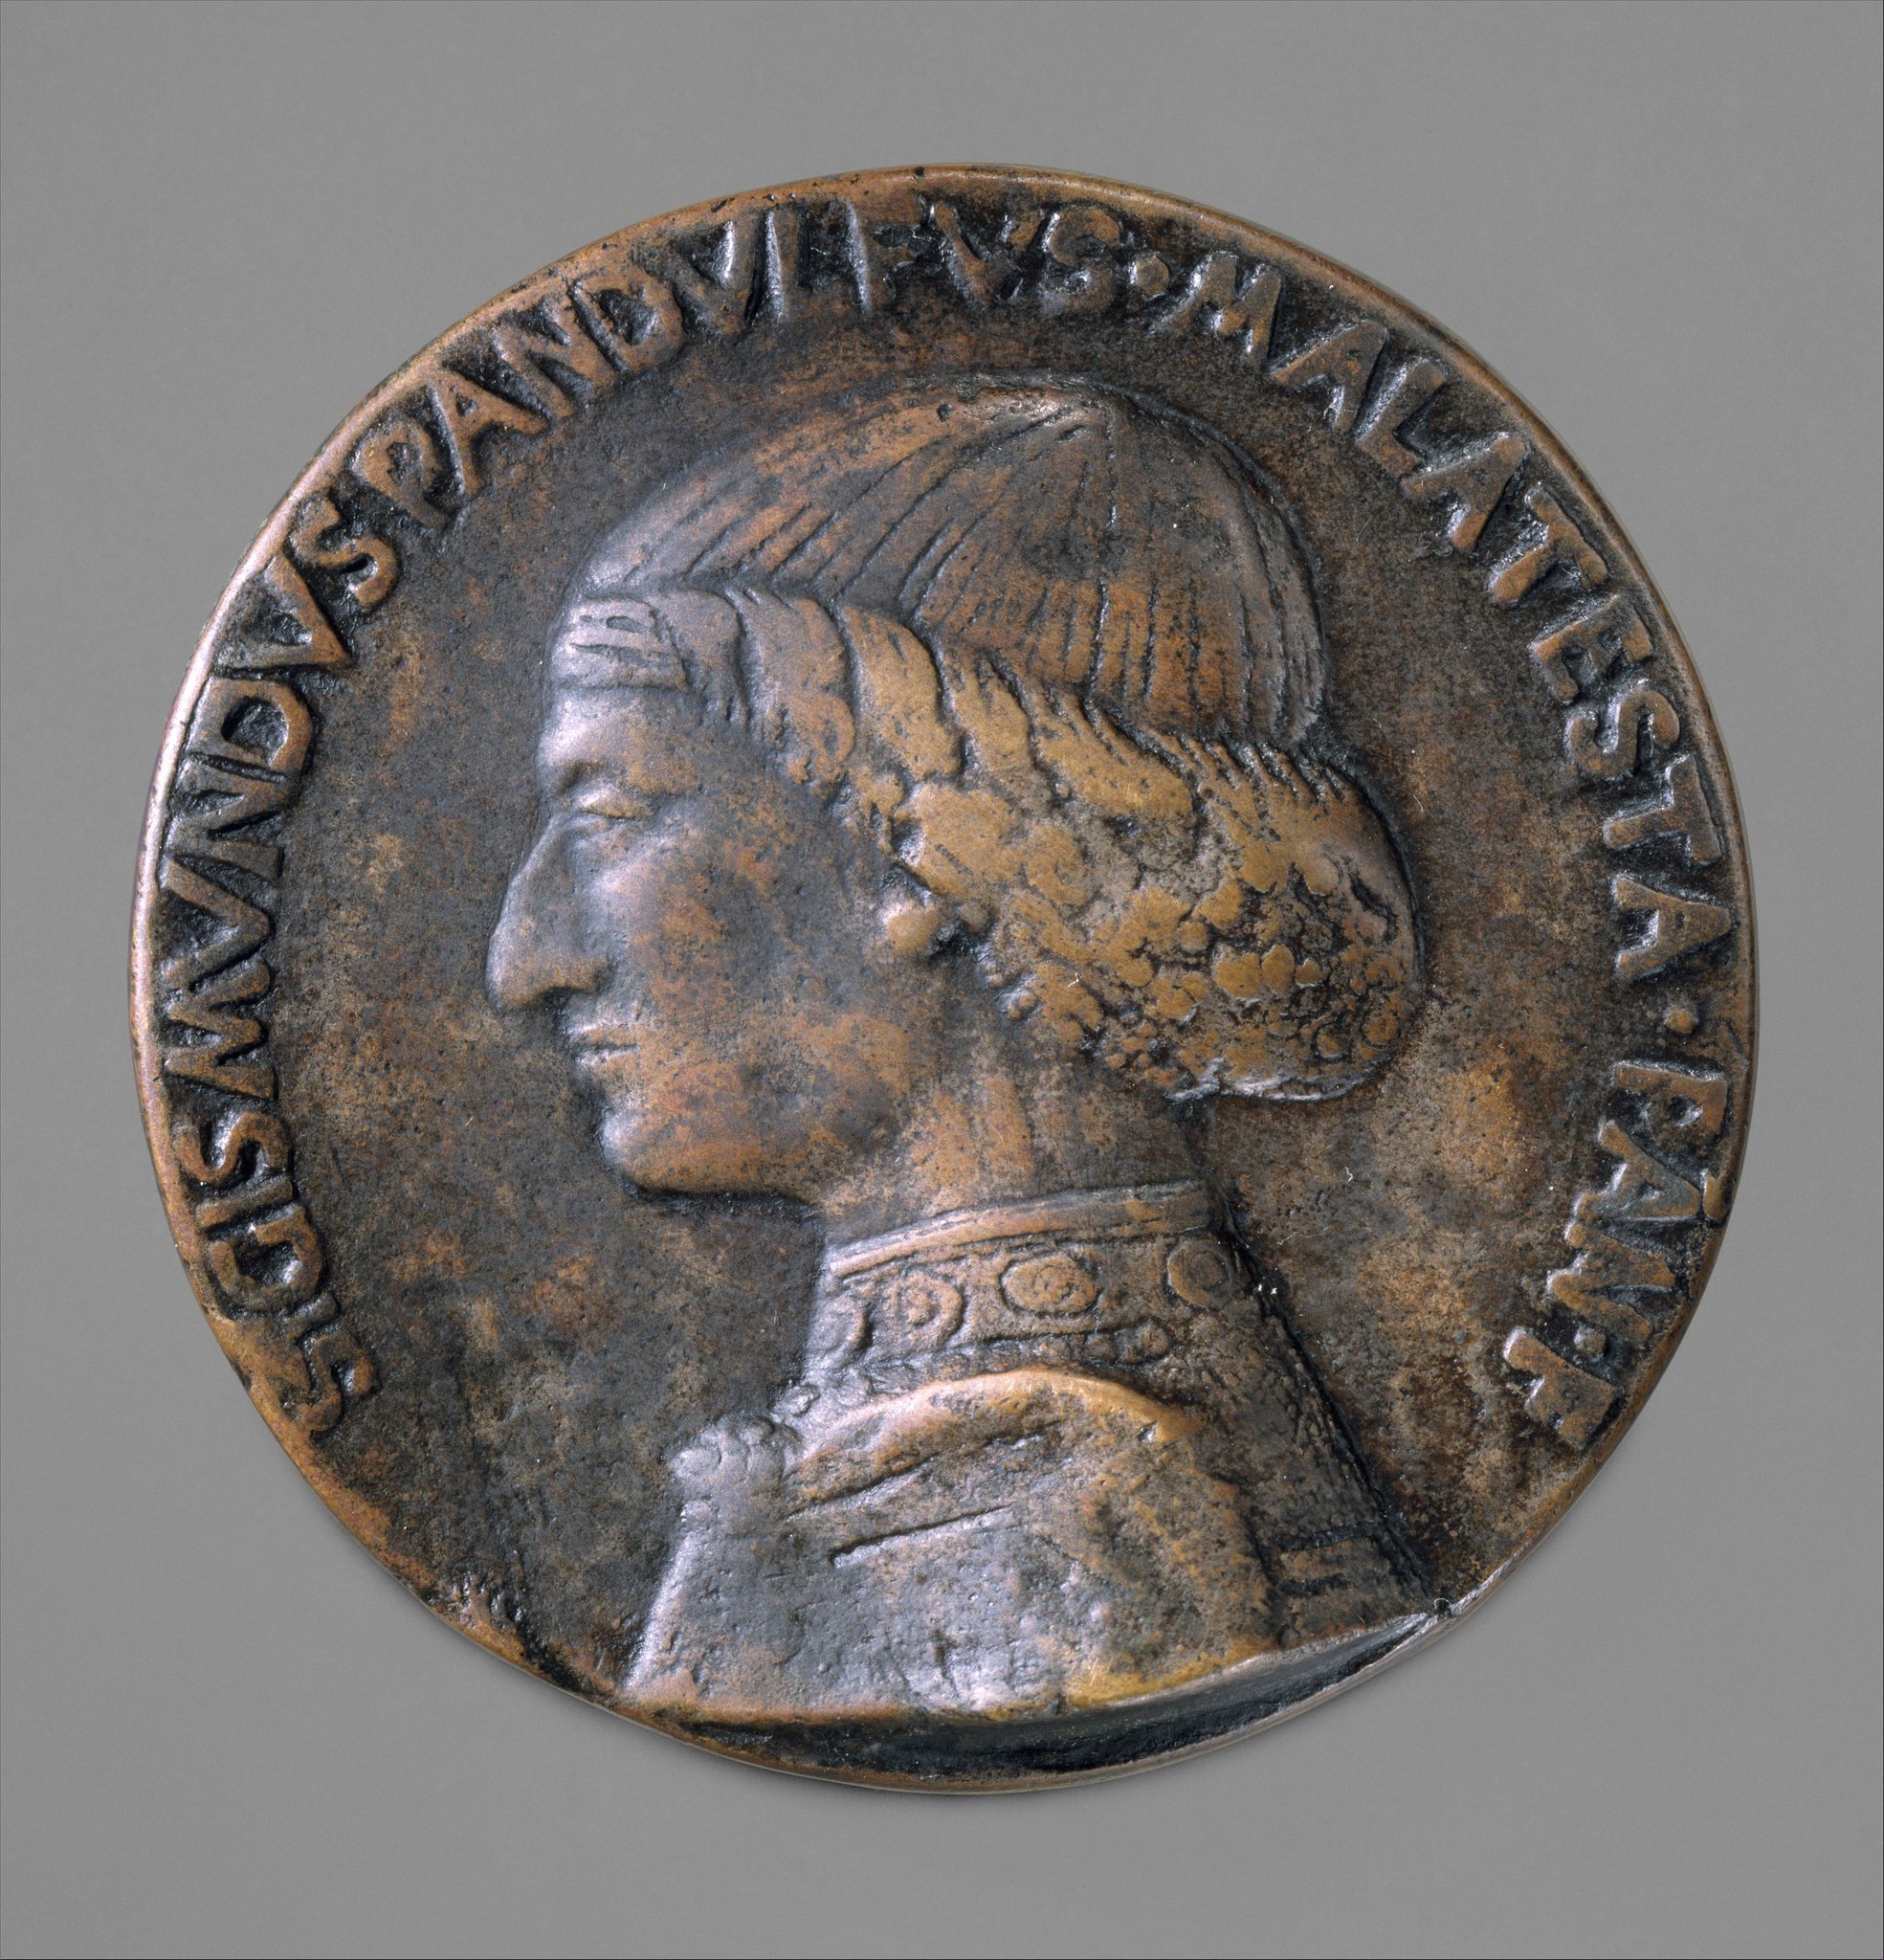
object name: medal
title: Medal: Sigismondo Pandolfo Malatesta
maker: matteo de' pasti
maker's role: artist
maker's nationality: italian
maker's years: 1420-1467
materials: copper alloy, patina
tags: men,portraits